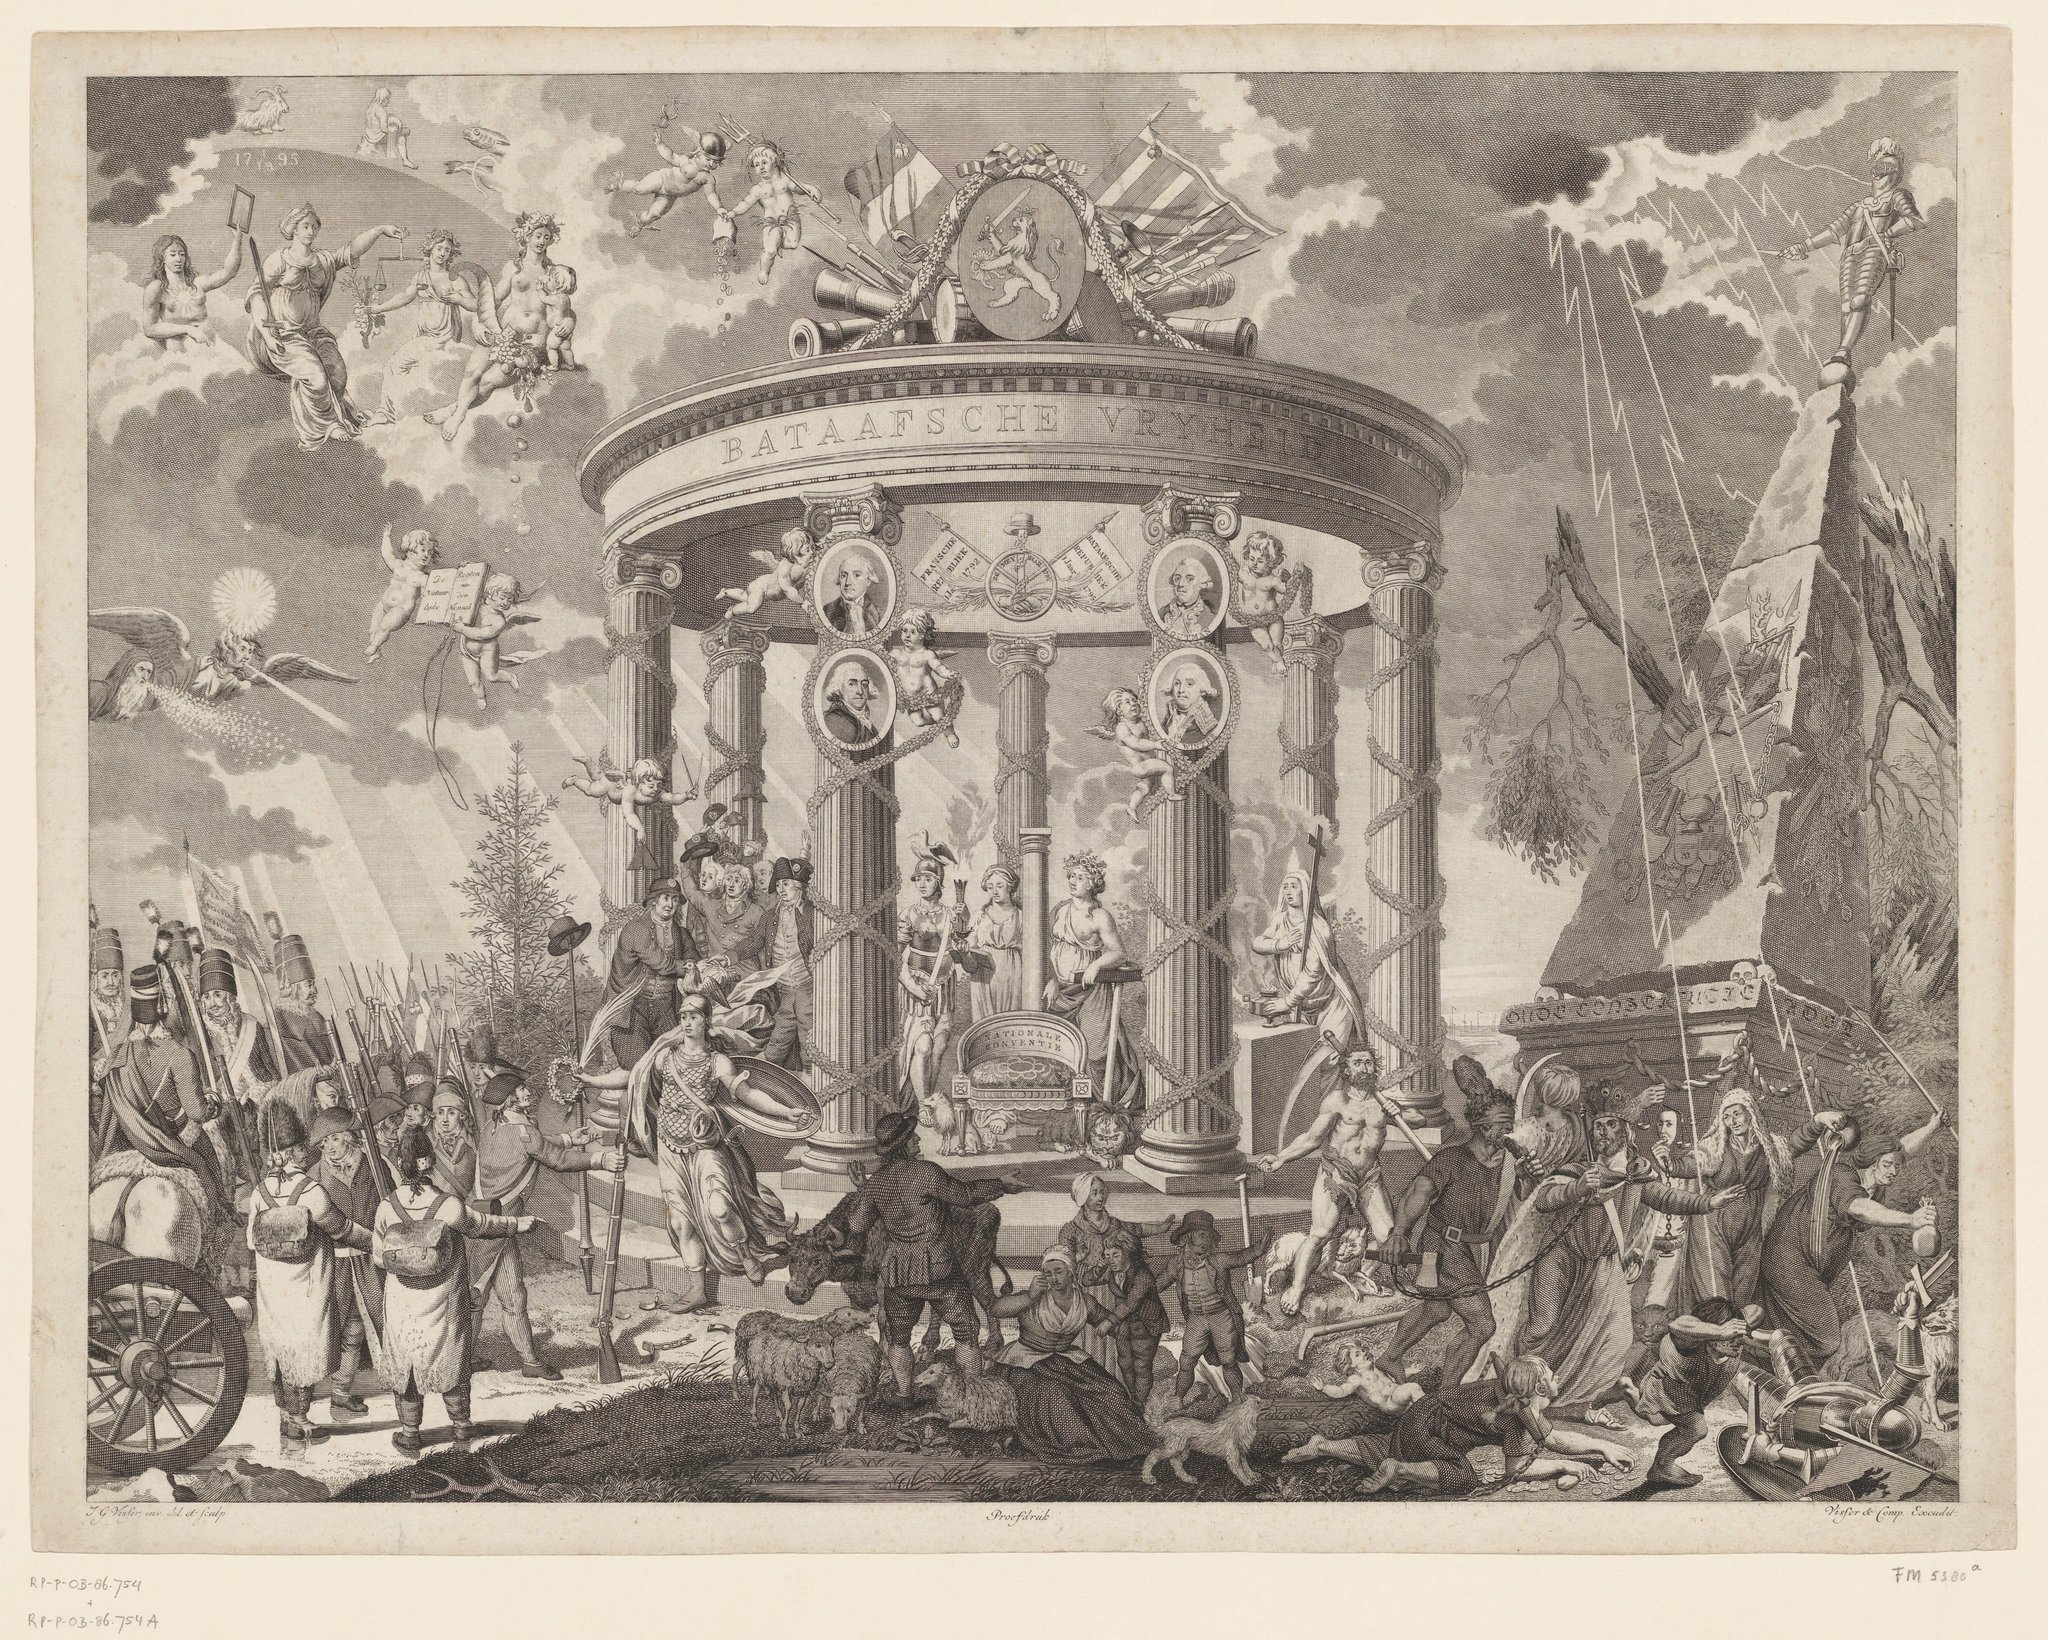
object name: print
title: Tempel van de Bataafse Vrijheid, 1795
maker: jan gerritsz. visser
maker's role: print maker, publisher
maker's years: 1745-1821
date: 1795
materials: paper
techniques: engraving, etching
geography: amsterdam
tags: the hague, johan arnold zoutman, herman willem daendels, politician, joan derk van der capellen tot den pol, paris, jan willem de winter, freedom, liberty; 'libertà' (ripa) (+ abstract concept represented by female figure)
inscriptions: collector's mark: Lugt 2228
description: Allegorie op de Vrijheid, 1795. De Bataafse Vrijheid treedt uit een open tempel om de Franse troepen, die over het ijs aankomen, te verwelkomen. Aan de zuilen van de tempel hangen portretten van verdienstelijke Patriotten. De zetel van de Nationale Conventie is leeg. Rechts wordt de zuil met een ridder aangeduid als 'Oude Constitutie Adel' door bliksem getroffen en valt om. Slavernij, Hoogmoed, Gierigheid en Valsheid vluchten. Bij de prent behoort een verklaring.